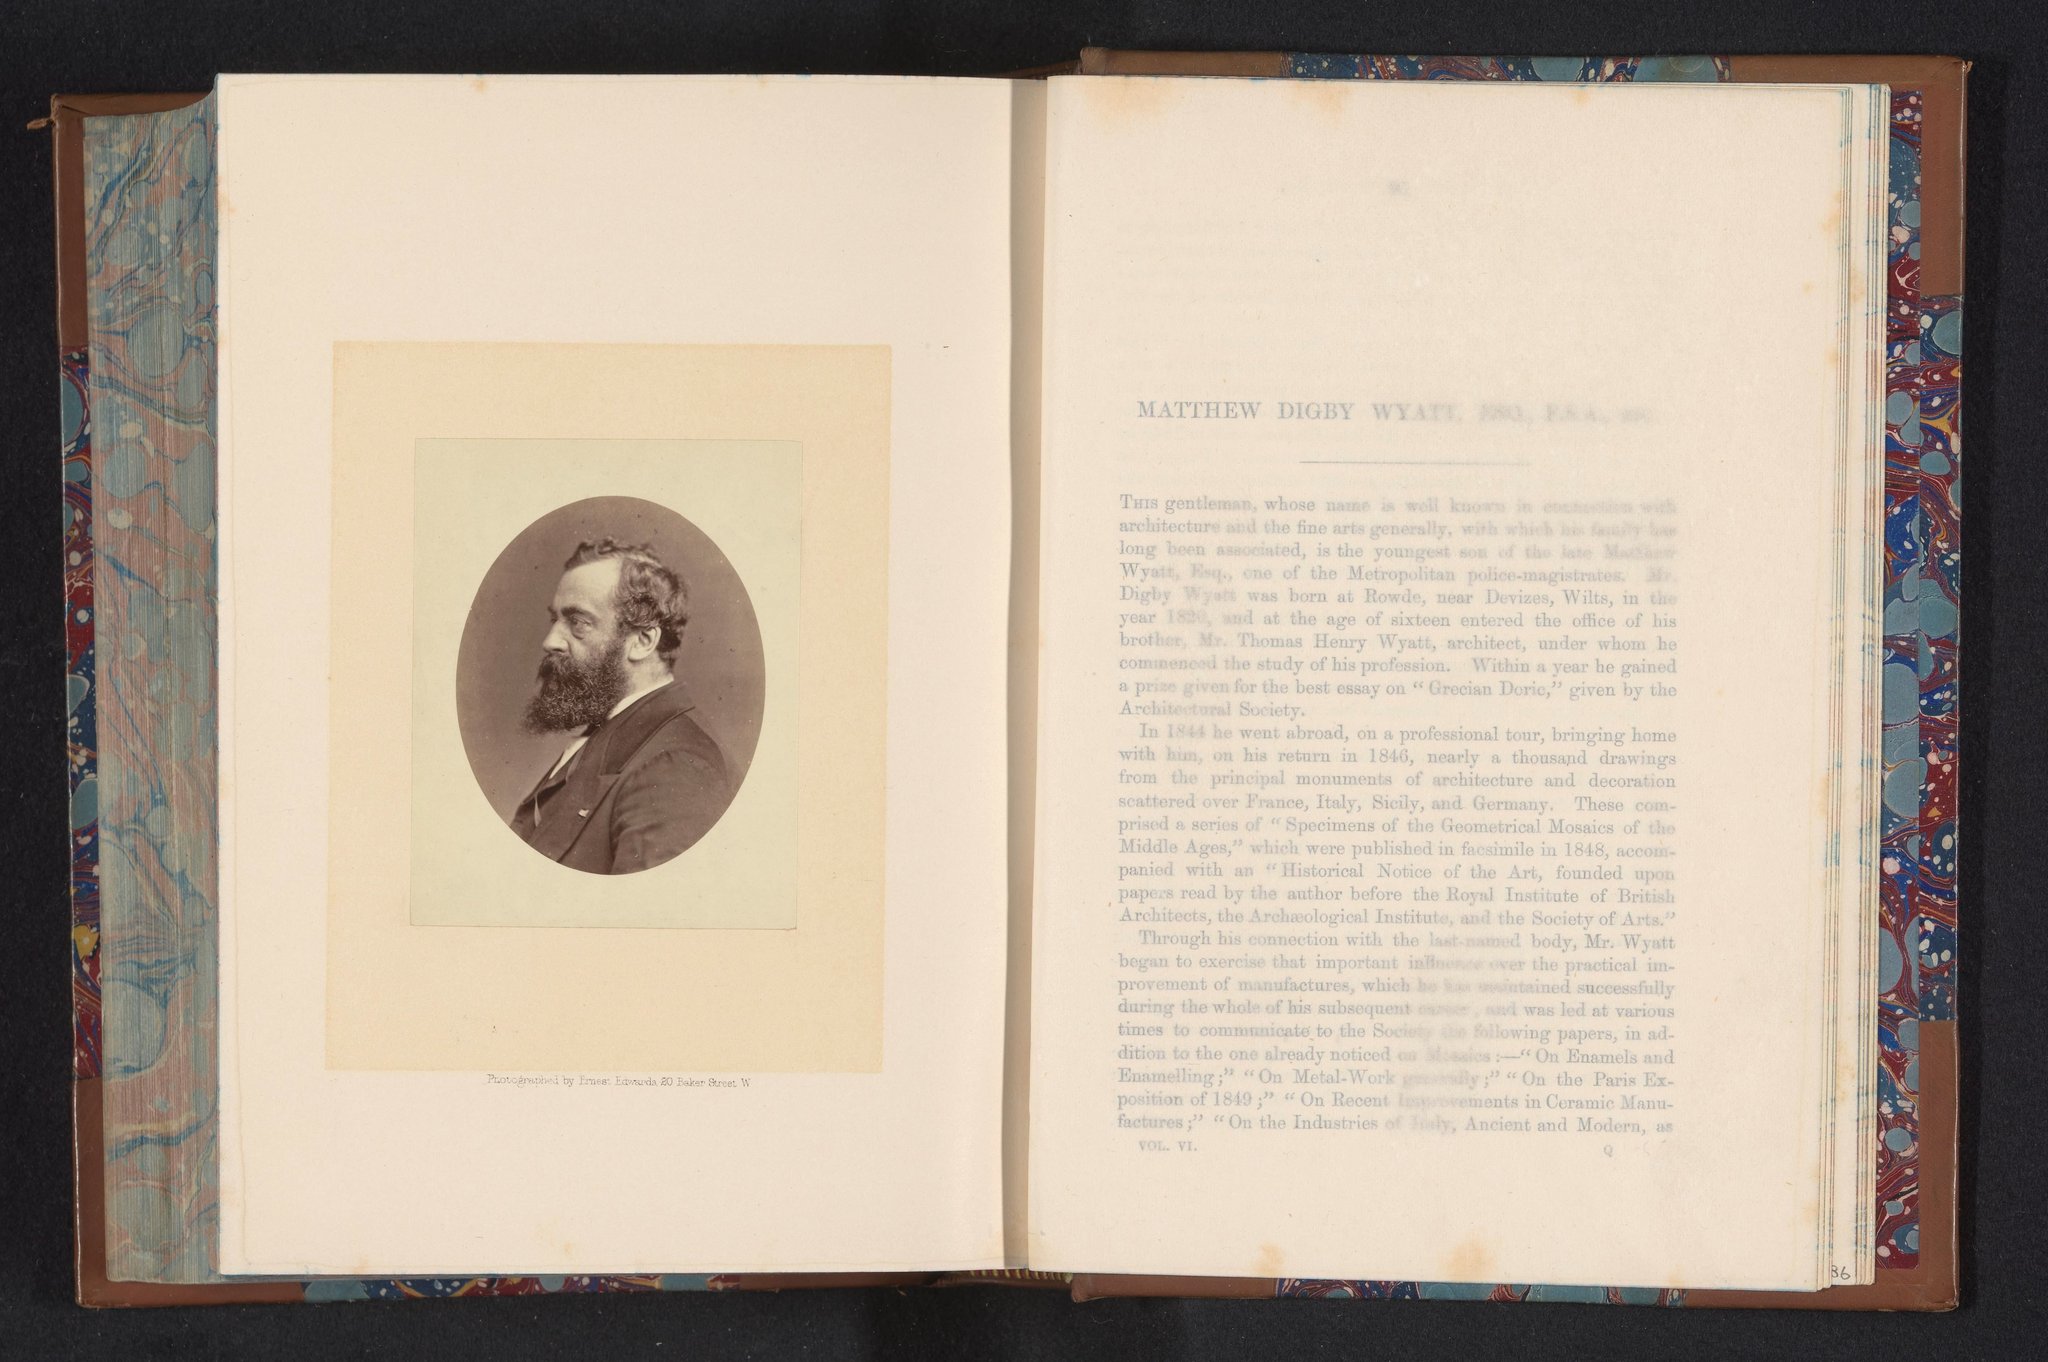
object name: page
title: Portret van Matthew Digby Wyatt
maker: ernest edwards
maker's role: fotograaf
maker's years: 1837-1903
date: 1853-1867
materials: photographic support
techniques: albumen print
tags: portrait, self-portrait of architect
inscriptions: name: ‘Photographed by Ernest Edwards, 20, Baker Street. W.’